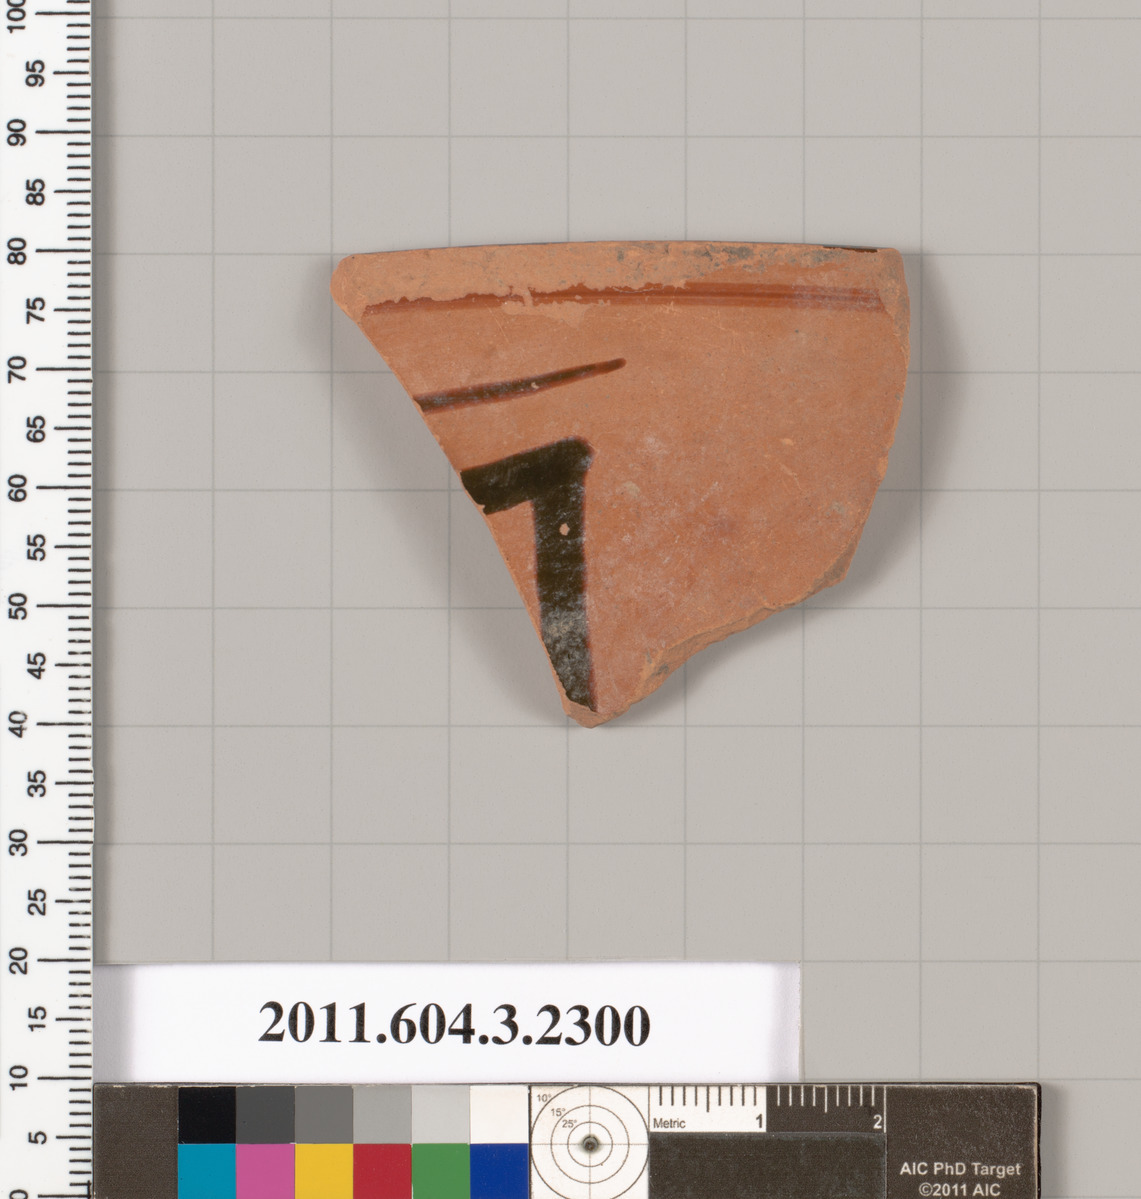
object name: kylix fragment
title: Terracotta rim fragment of a kylix: eye-cup (drinking cup)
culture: greek, attic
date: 540-530 BCE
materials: terracotta